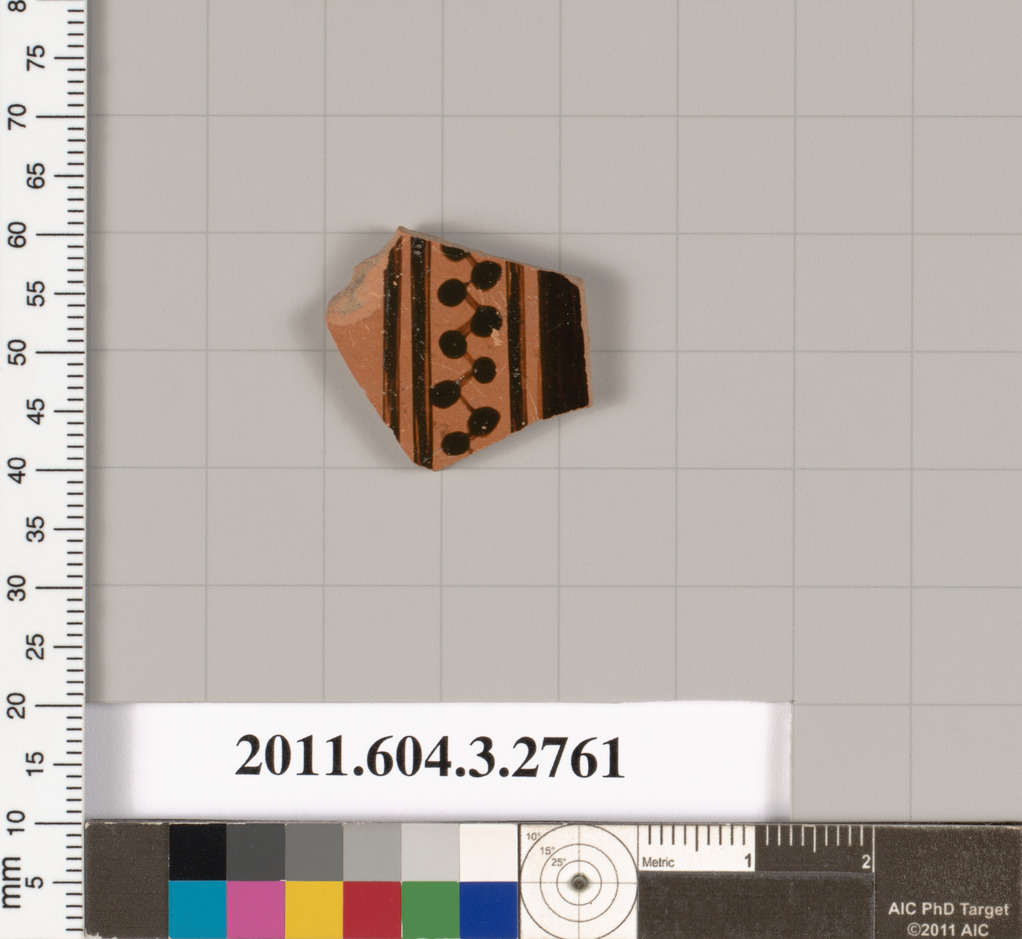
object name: oinochoe fragment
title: Terracotta fragment of an oinochoe (jug)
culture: greek, attic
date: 525-501 BCE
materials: terracotta